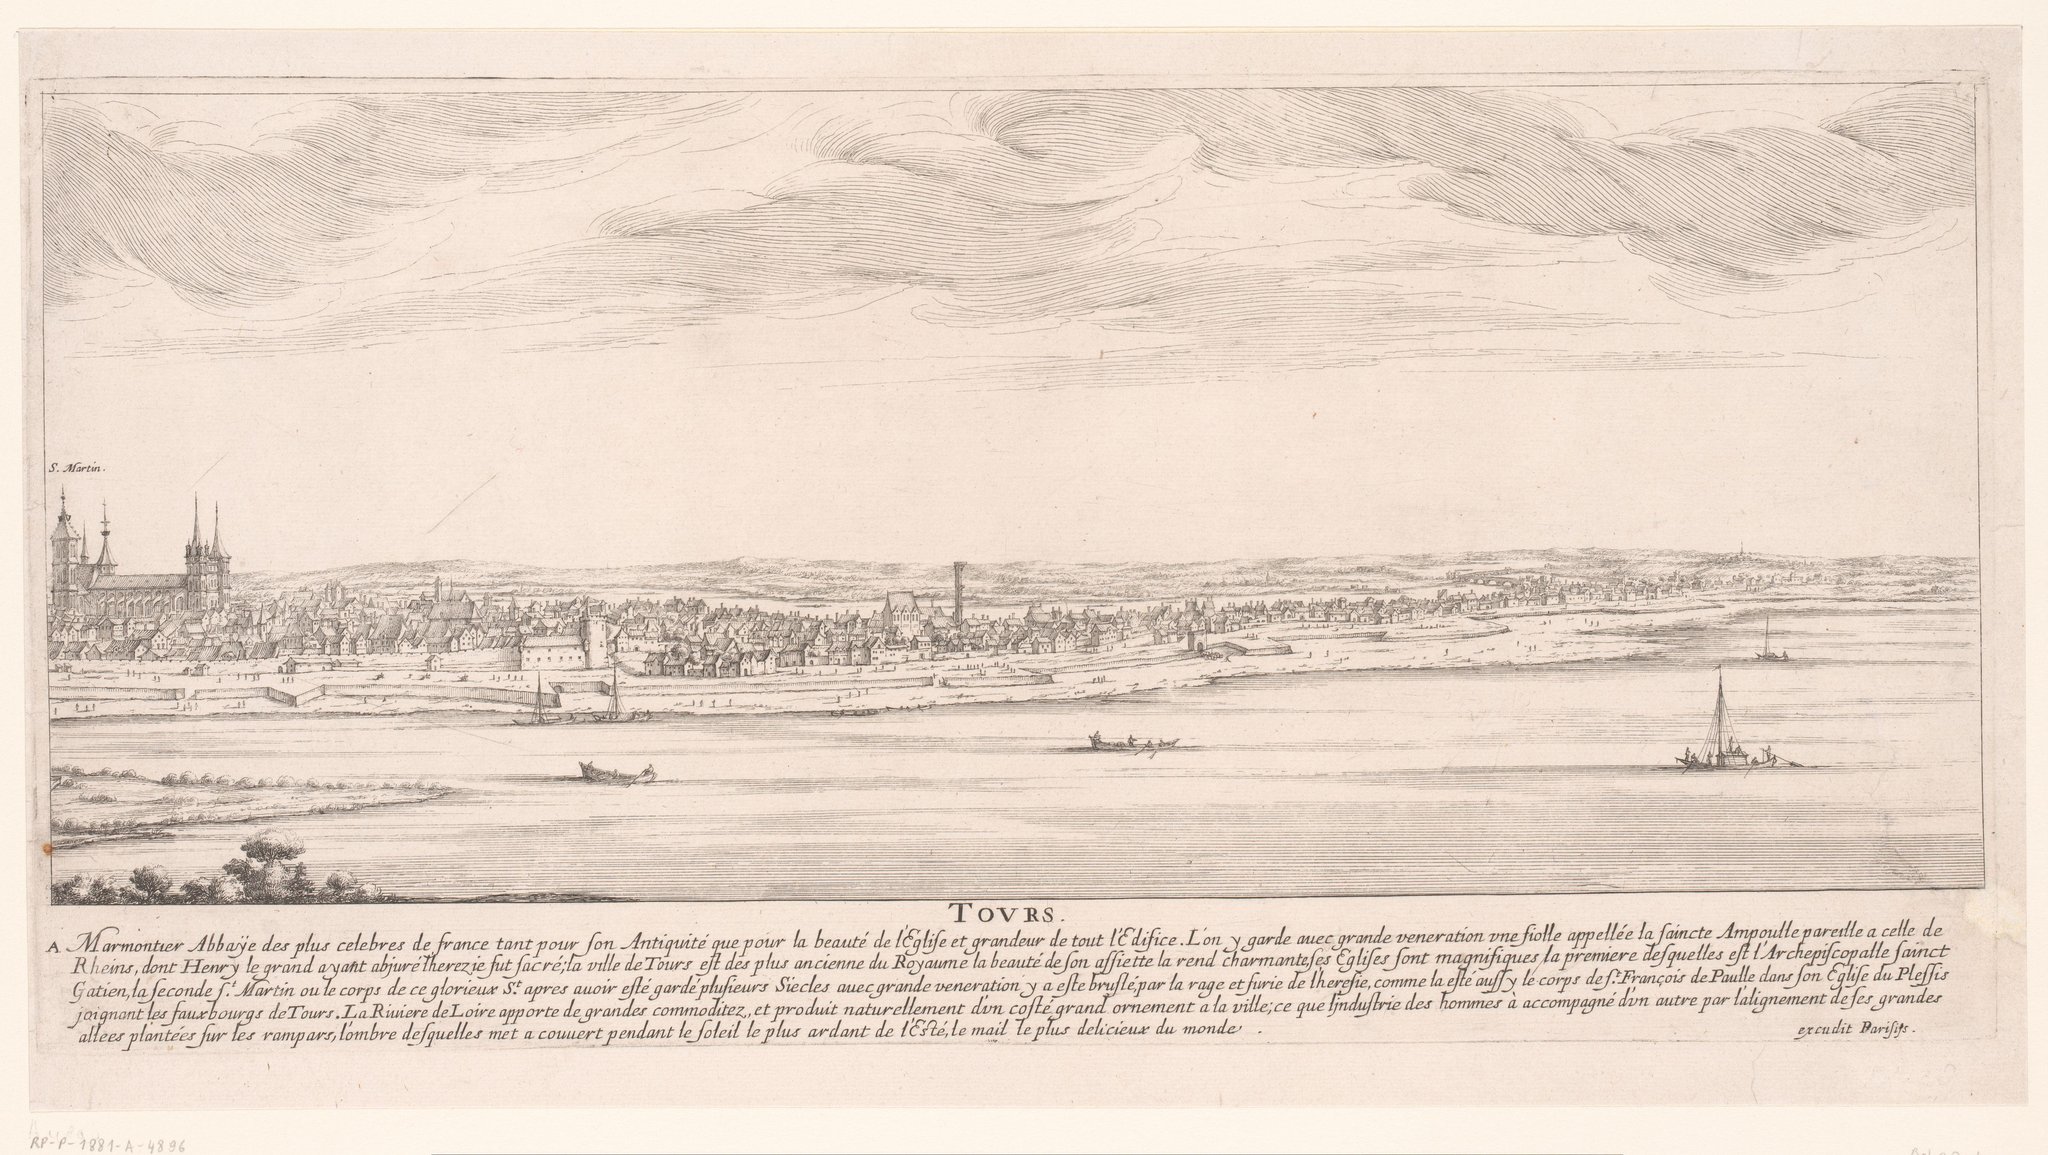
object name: print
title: Tours.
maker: françois collignon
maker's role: print maker, publisher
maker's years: 1610-1687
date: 1620-1687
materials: paper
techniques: etching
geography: paris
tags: city-view in general; 'veduta', river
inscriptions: watermark, collector's mark: Lugt 2228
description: Het tweede deel van deze prent met het Latijnse onderschrift ontbreekt.